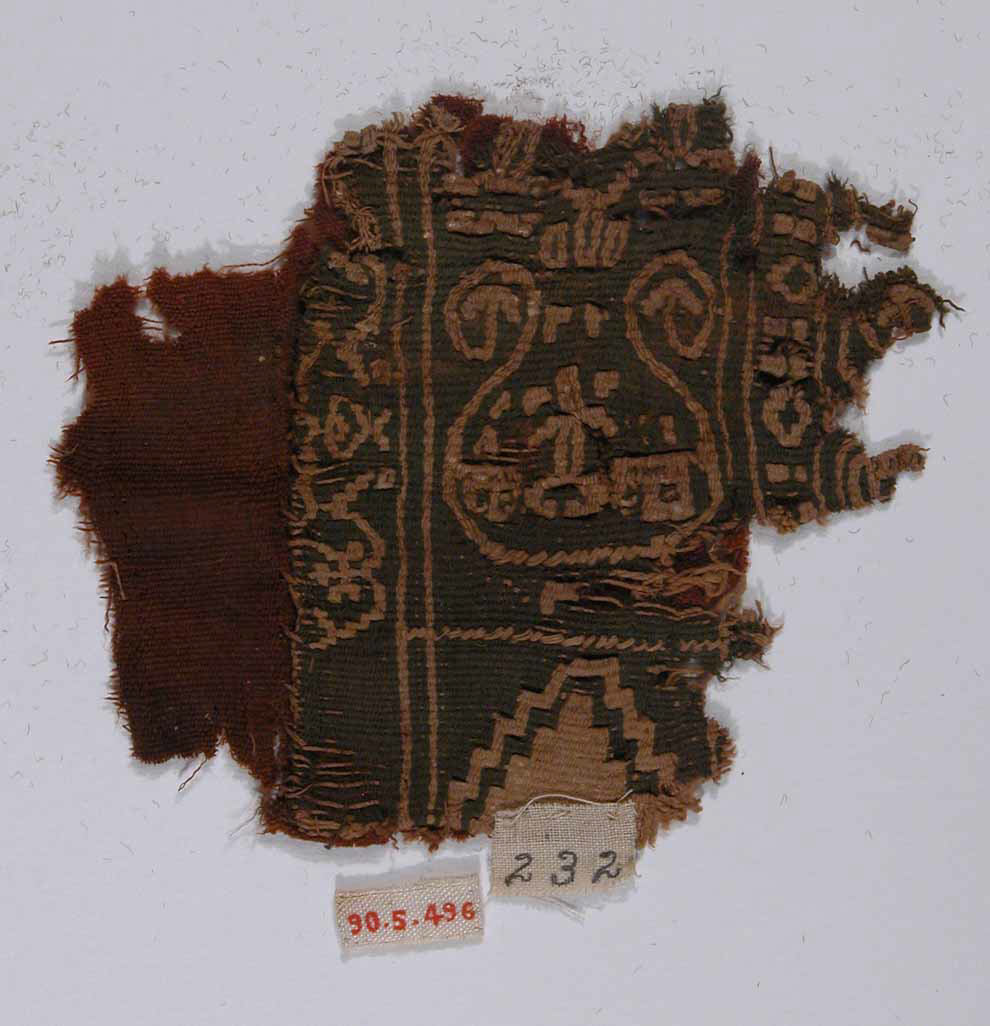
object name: textile fragment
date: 301-500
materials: linen, wool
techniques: weave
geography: egypt